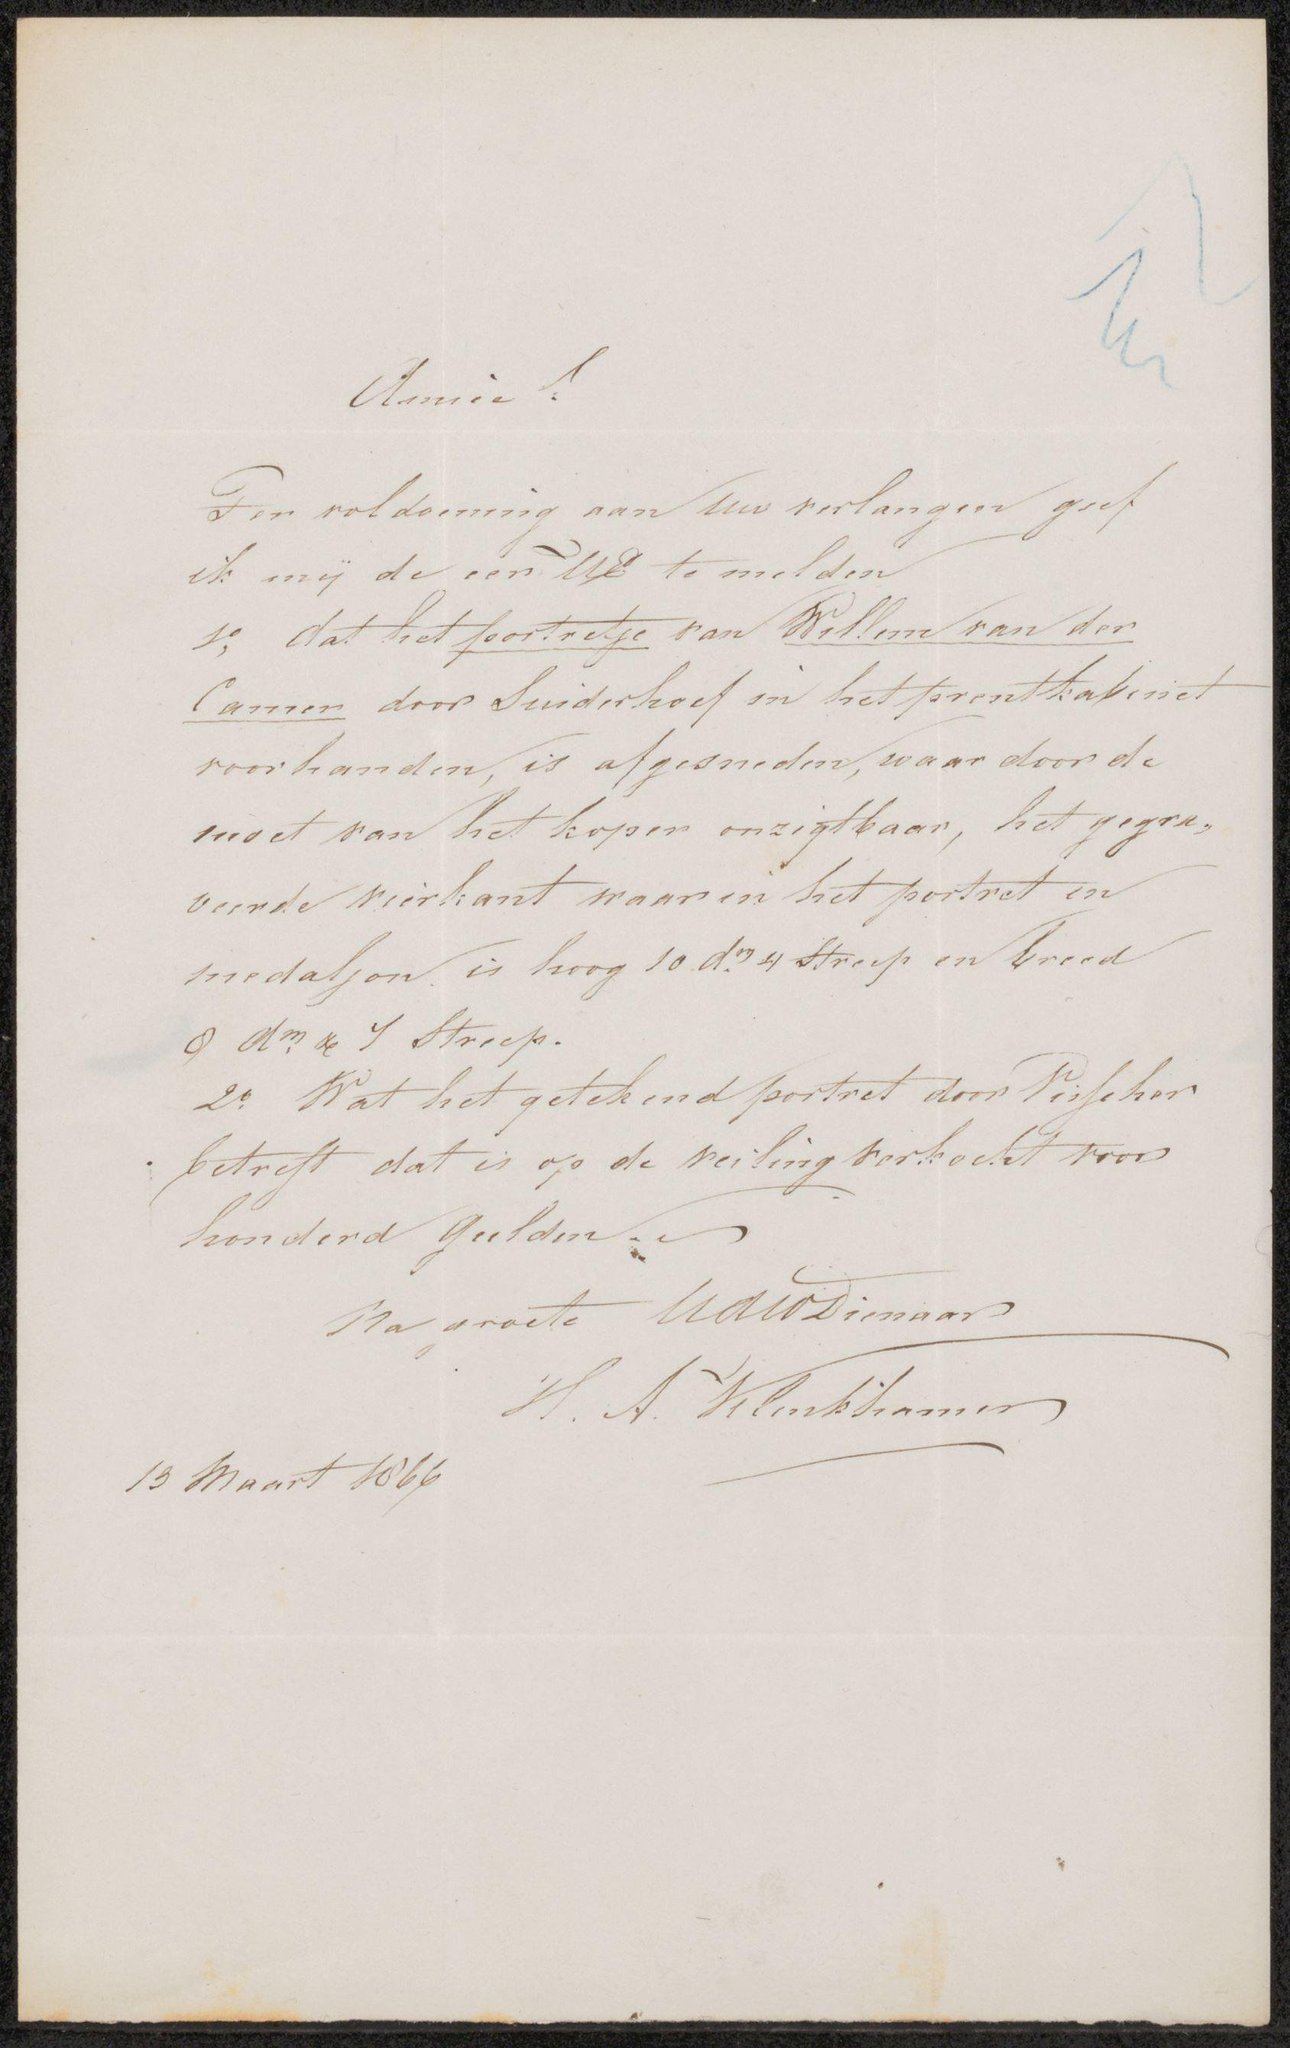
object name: letter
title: Brief aan Adriaan van der Willigen Pz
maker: hendrik abraham klinkhamer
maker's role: draughtsman, painter, print maker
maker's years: 1810-1872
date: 1866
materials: ink, paper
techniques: pen, writing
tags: haarlem, draughtsman, jonas suyderhoef, print room, drawing, the graphic arts, historical persons (portraits and scenes from the life)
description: RP-P-OB-60.711 is onderwerp van deze brief.